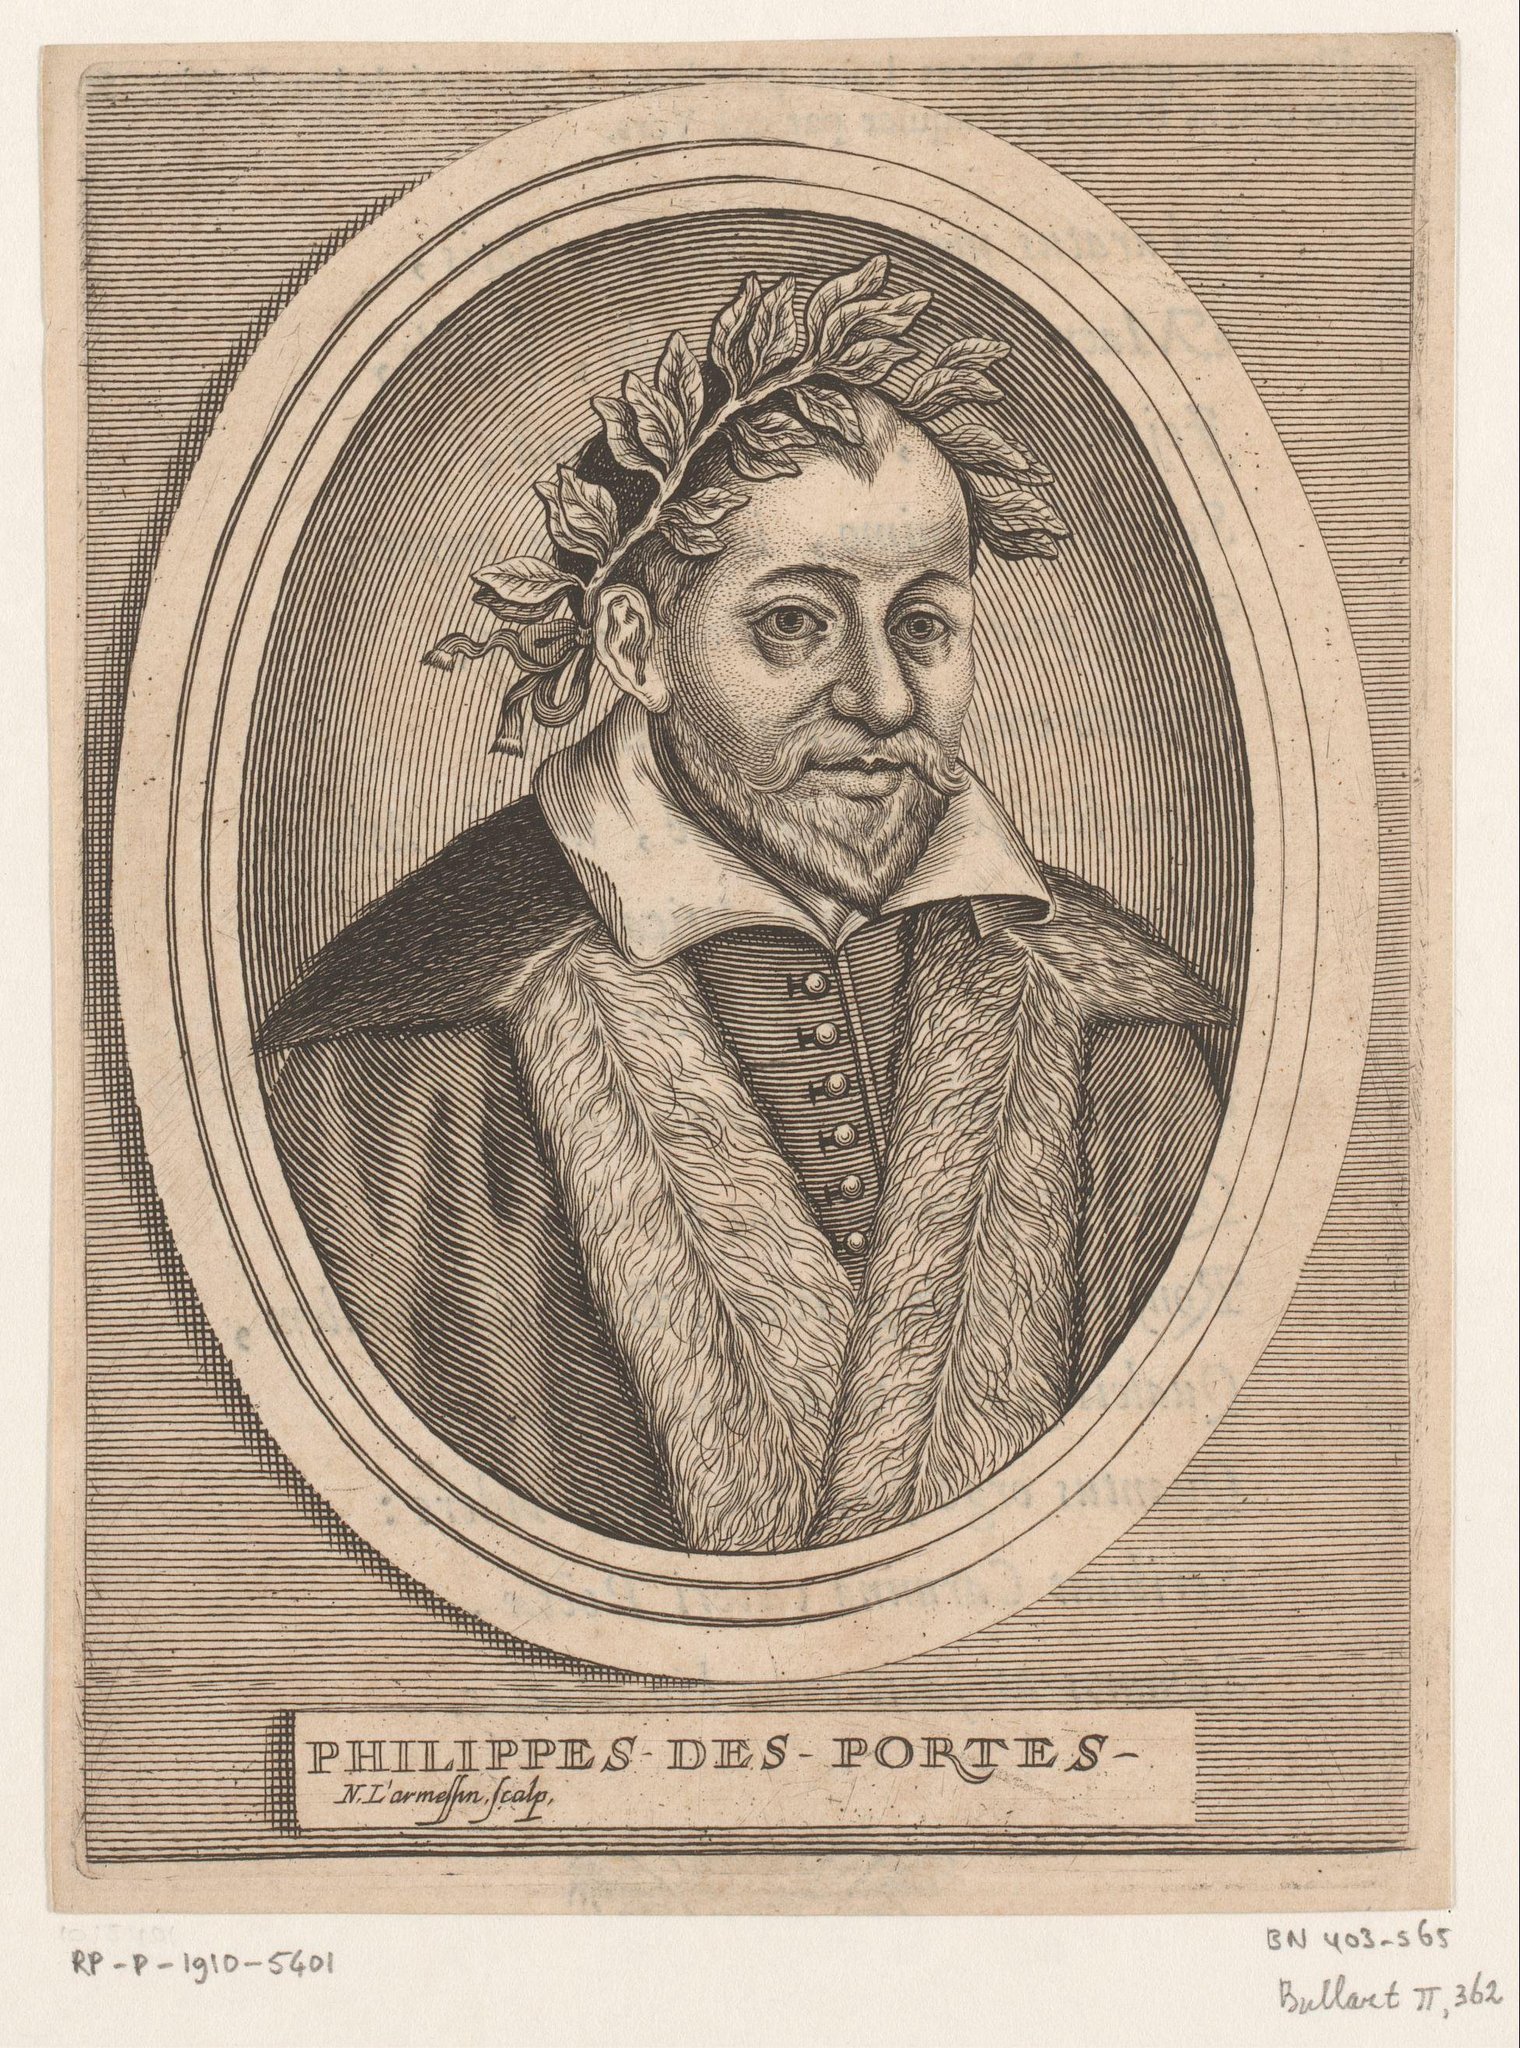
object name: book illustration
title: Portret van Philippe Desportes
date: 1682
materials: paper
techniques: engraving, letterpress printing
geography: brussels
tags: historical persons, portrait of a writer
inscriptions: collector's mark: Lugt 2228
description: Prent gebruikt voor: Bullart, Isaac. Académie des Sciences et Arts contenant les vies et éloges his. des hommes illustres qui ont excellé en ces professions depuis environ quatre siècles. Brussel: François Foppens, 1682. Het boek werd in 1682 eveneens in Amsterdam uitgegeven door de erfgenamen van Daniel Elzevier. Ieder portret betreft een illustratie bij de biografie van een kunstenaar of geleerde. De meeste portretten werden door Nicolas de Larmessin vervaardigd (162), 93 door De Boulonois en een derde door ongeïdentificeerde prentmakers. Dit betreft een illustratie op p. 362, deel II.